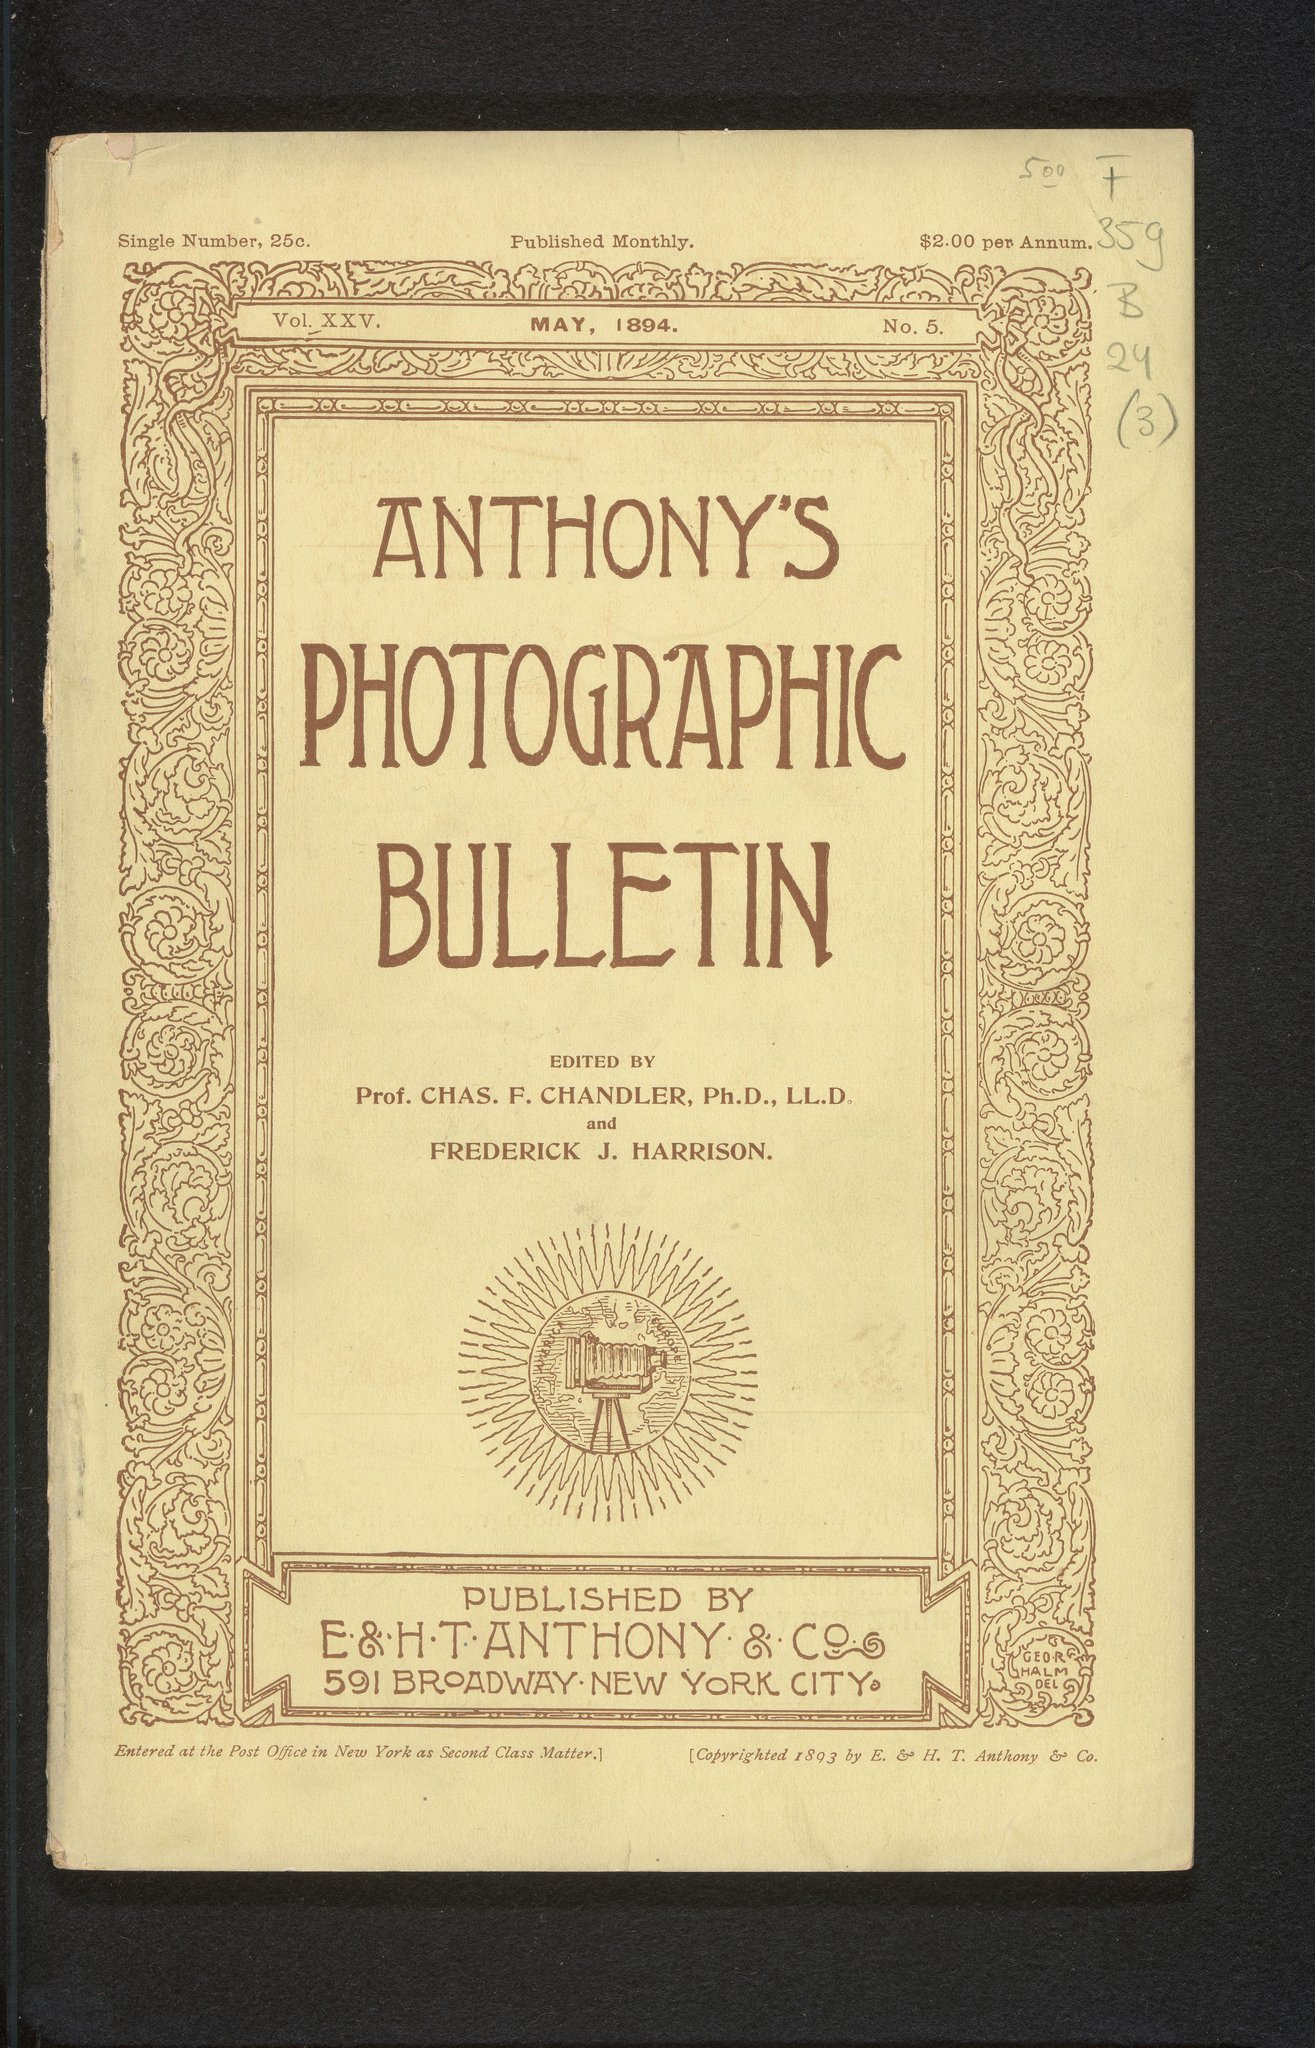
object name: book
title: Anthony's photographic bulletin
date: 1893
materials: paper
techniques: printing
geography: new york city